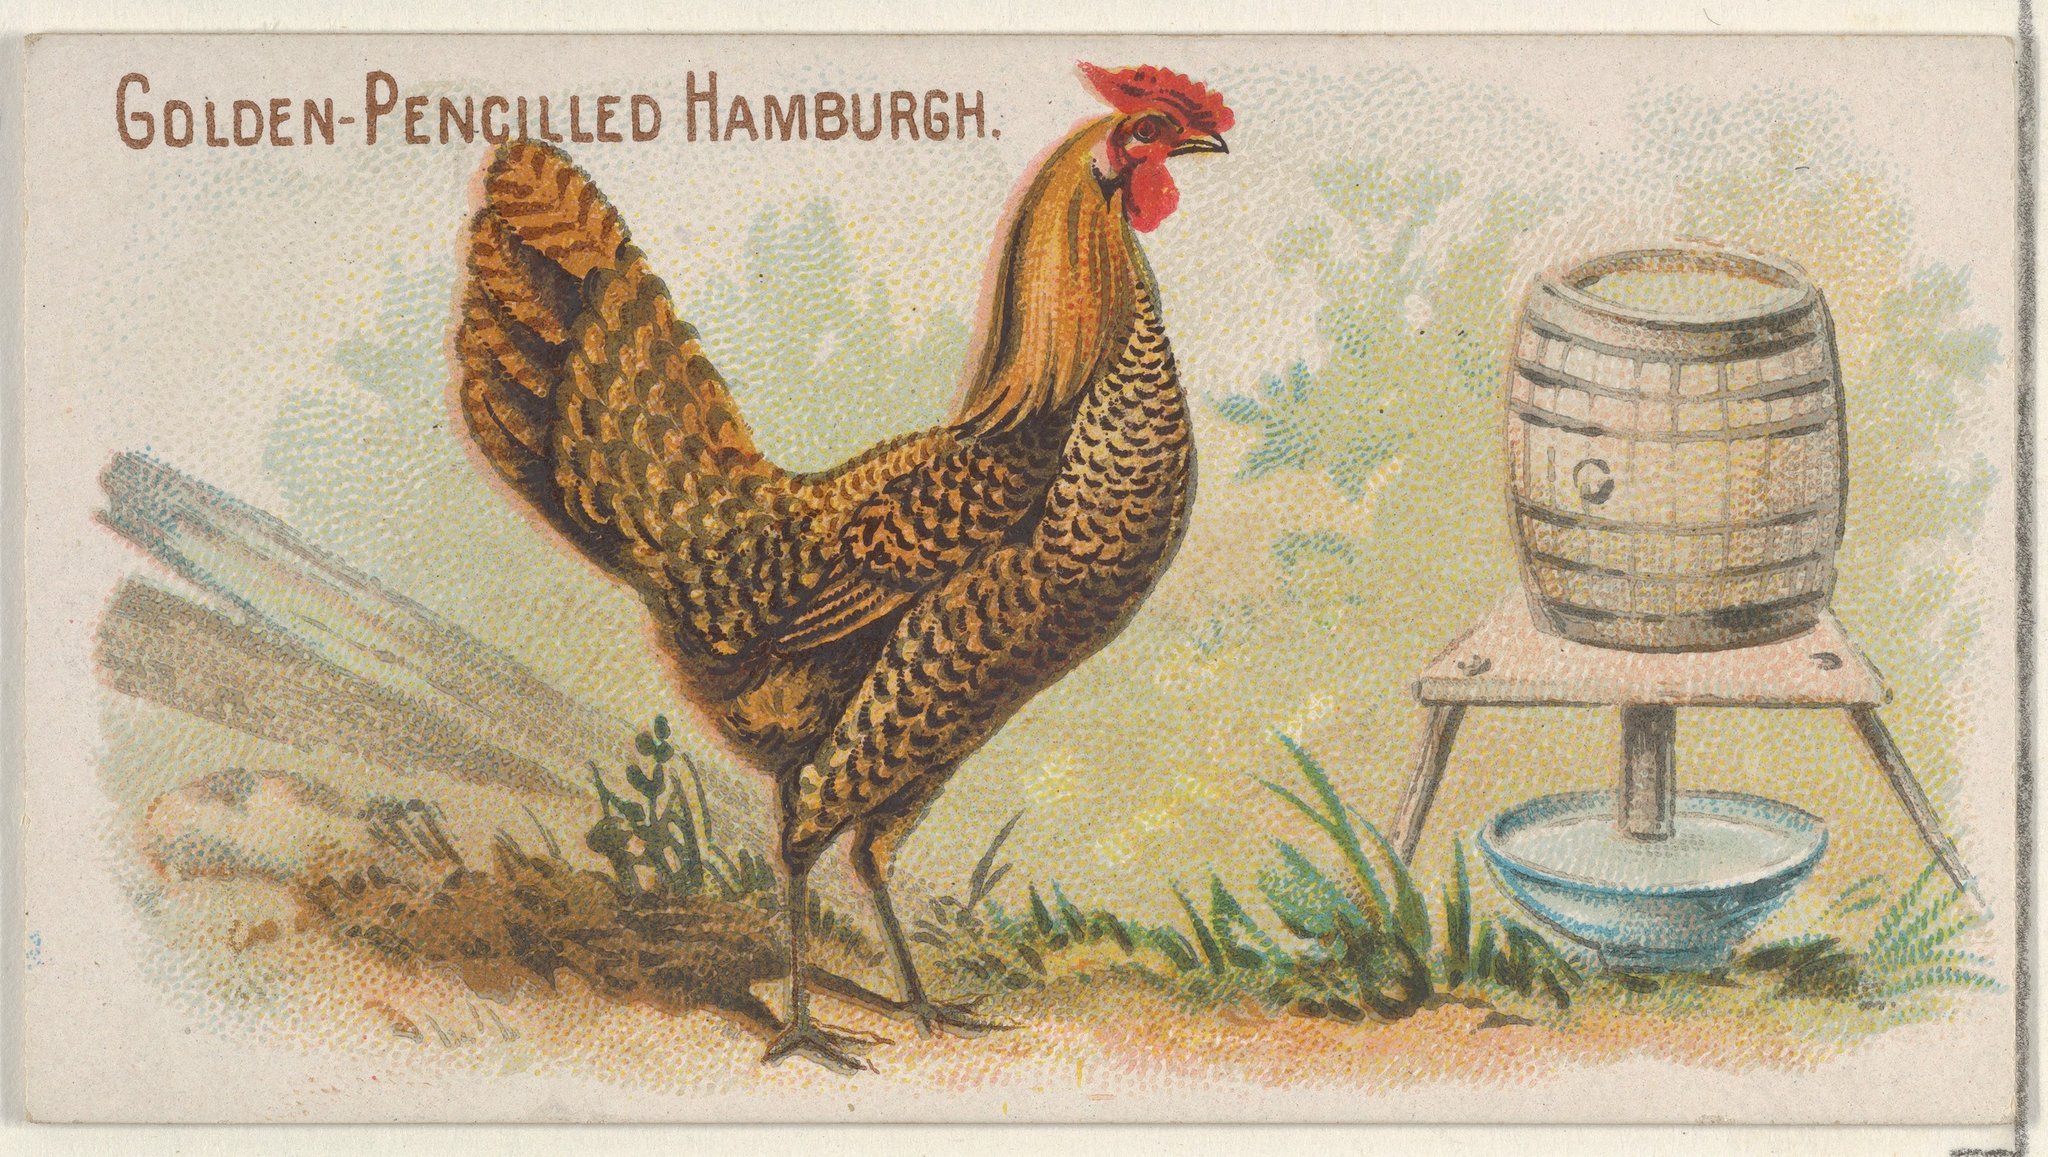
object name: print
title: Golden-Pencilled Hamburgh, from the Prize and Game Chickens series (N20) for Allen & Ginter Cigarettes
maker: allen & ginter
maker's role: publisher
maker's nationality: american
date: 1891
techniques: color lithograph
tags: chickens